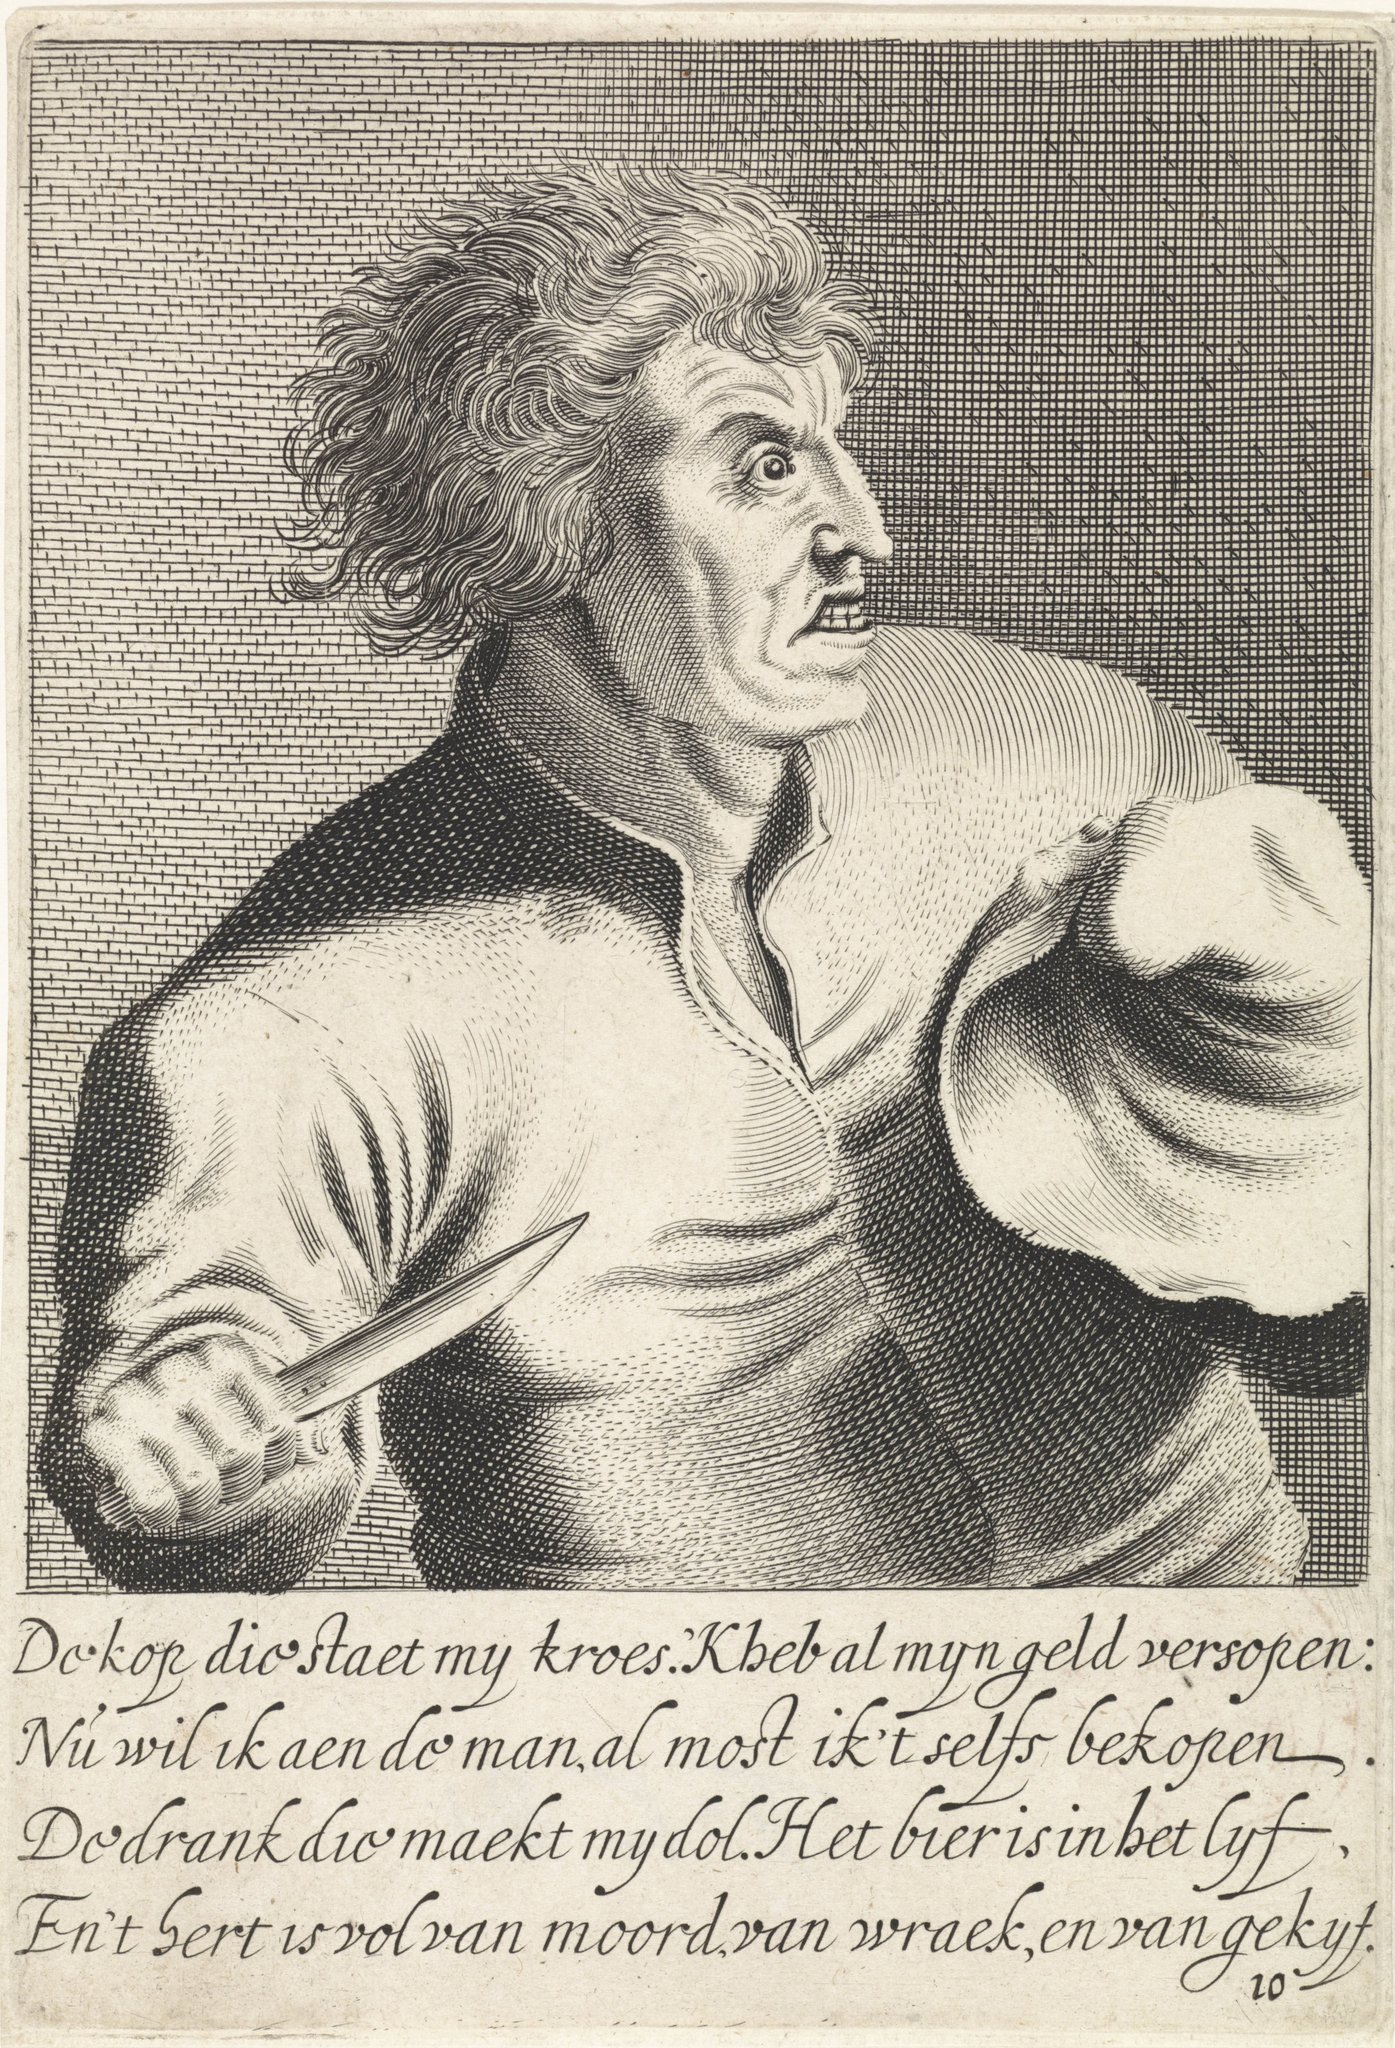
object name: print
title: Spiegel van ijdelheid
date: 1633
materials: paper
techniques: engraving, etching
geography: amsterdam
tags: drunkard, tools, aids, implements ~ crafts and industries: knife, fighting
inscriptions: collector's mark: Lugt 240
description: Een dronken man met een hoed in zijn ene en een mes in zijn andere hand. Tiende prent uit een serie van achttien.